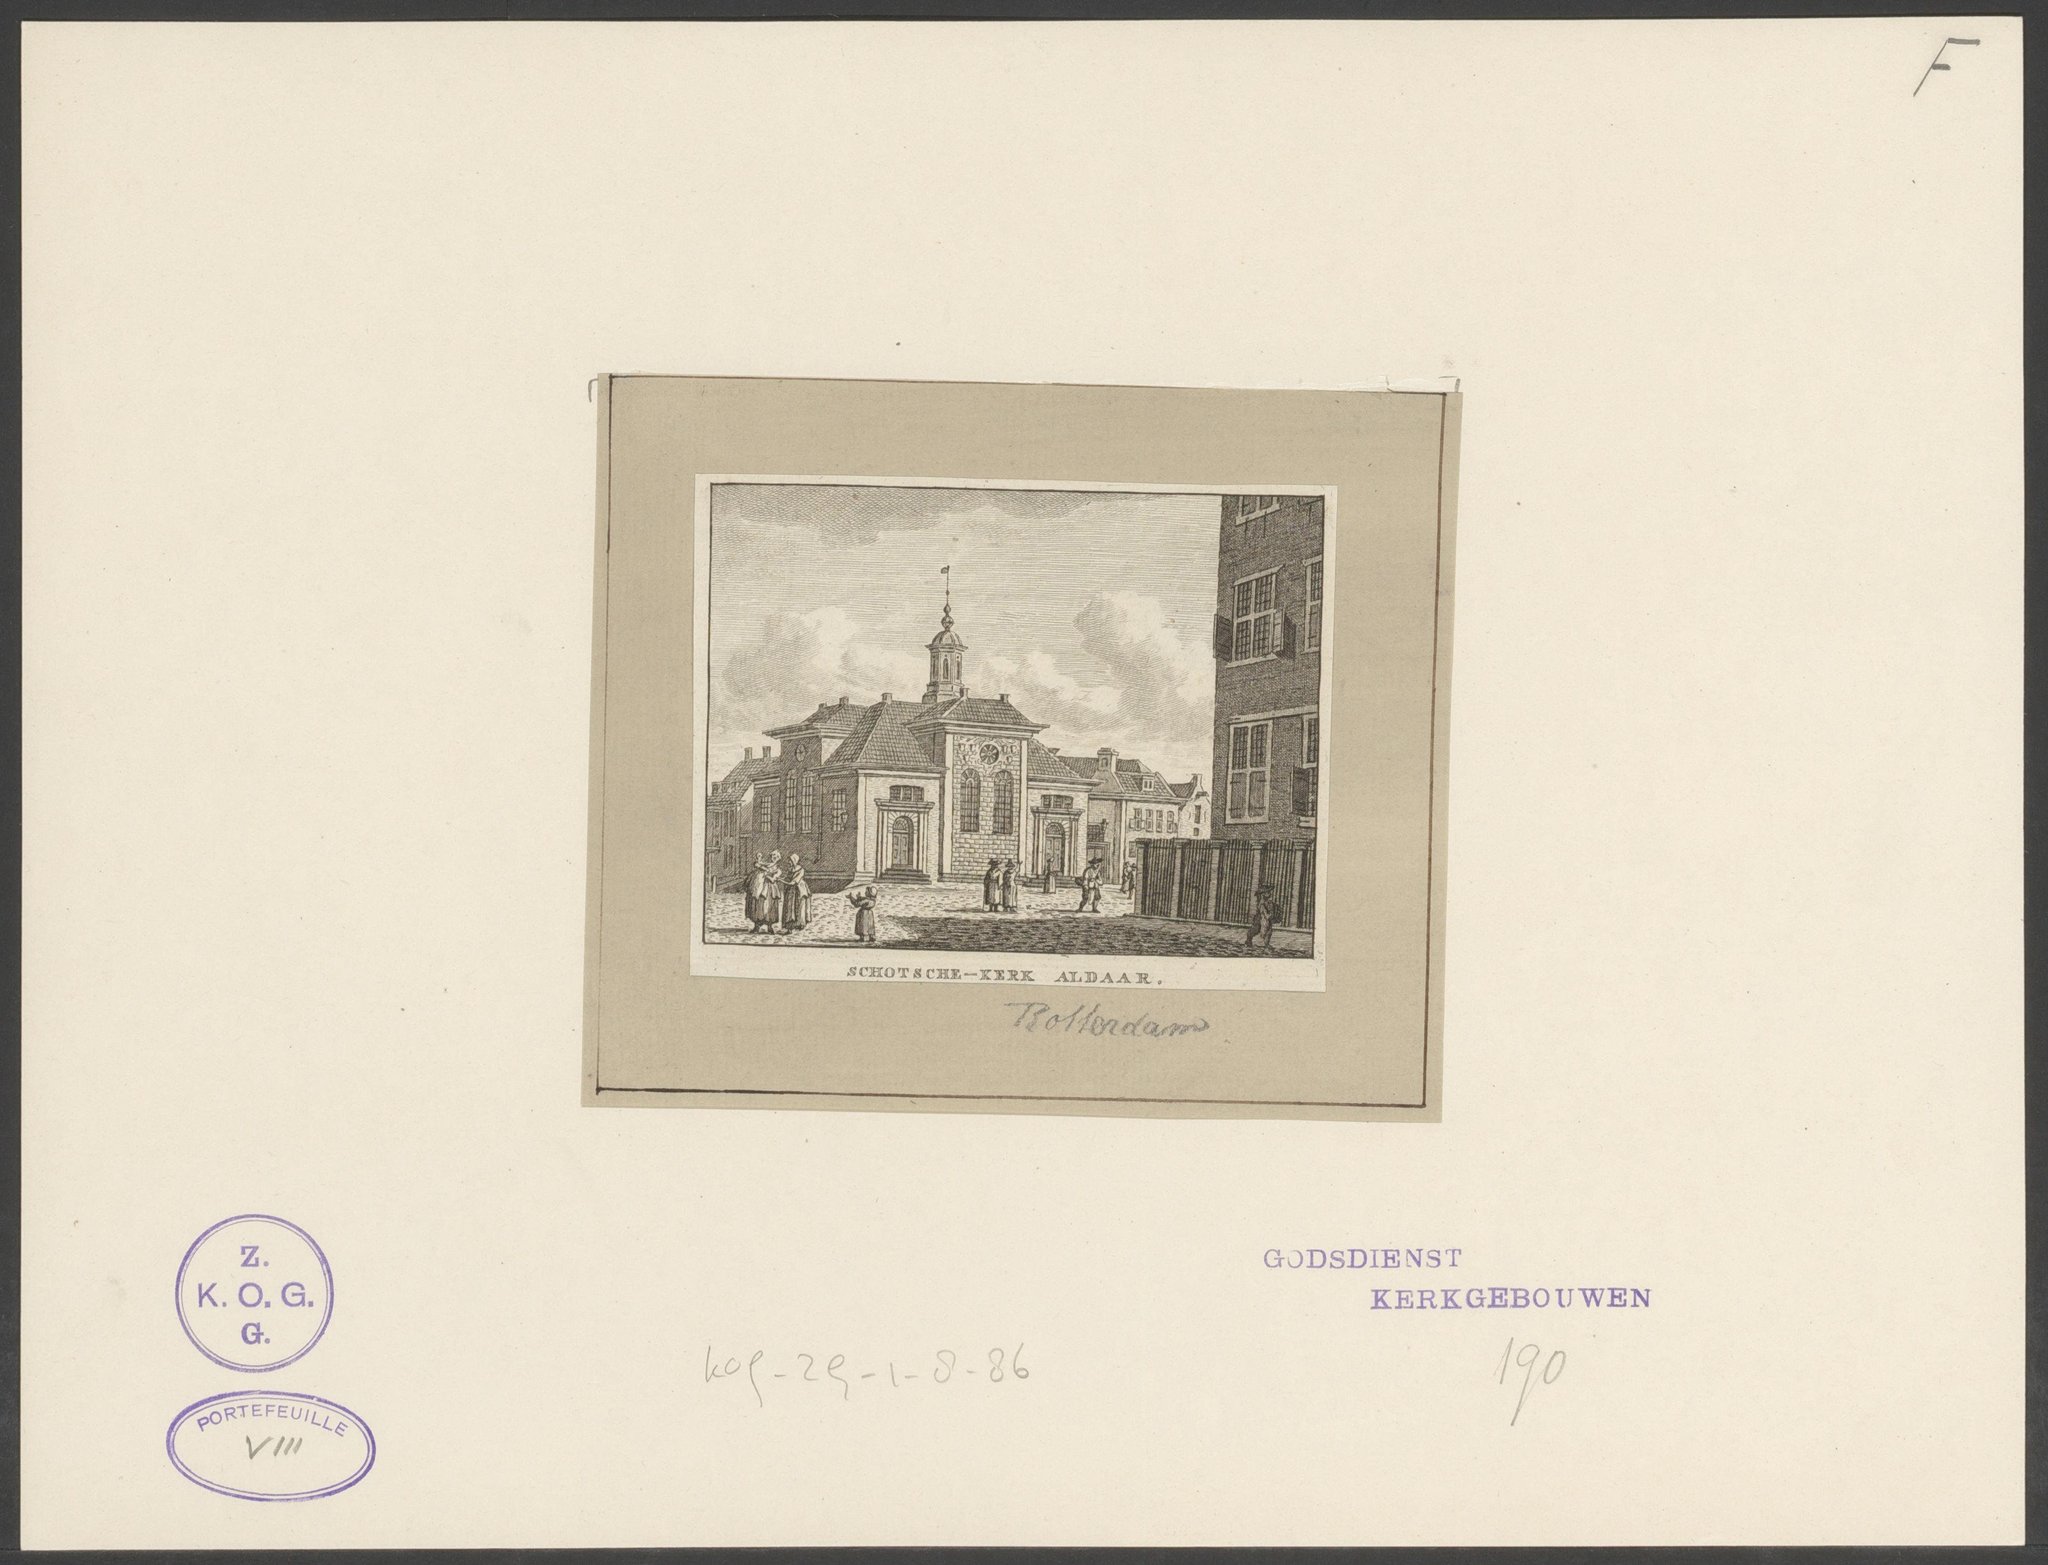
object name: print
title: Schotse kerk te Rotterdam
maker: carel frederik bendorp (i)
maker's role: print maker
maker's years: 1736-1814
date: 1790-1793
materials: paper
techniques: engraving, etching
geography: amersfoort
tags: church (exterior)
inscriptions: collector's mark: Lugt 1641, collector's mark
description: Gezicht op de Schotse kerk te Rotterdam. Onderste helft van een plaat oorspronkelijk met twee voorstellingen. Onderwerpsrubrieken binnen de Atlas Zeden en Gewoonten: Kerk en kerkwezen & Armwezen en liefdadige instellingen; Kerkgebouwen elders. M-U.